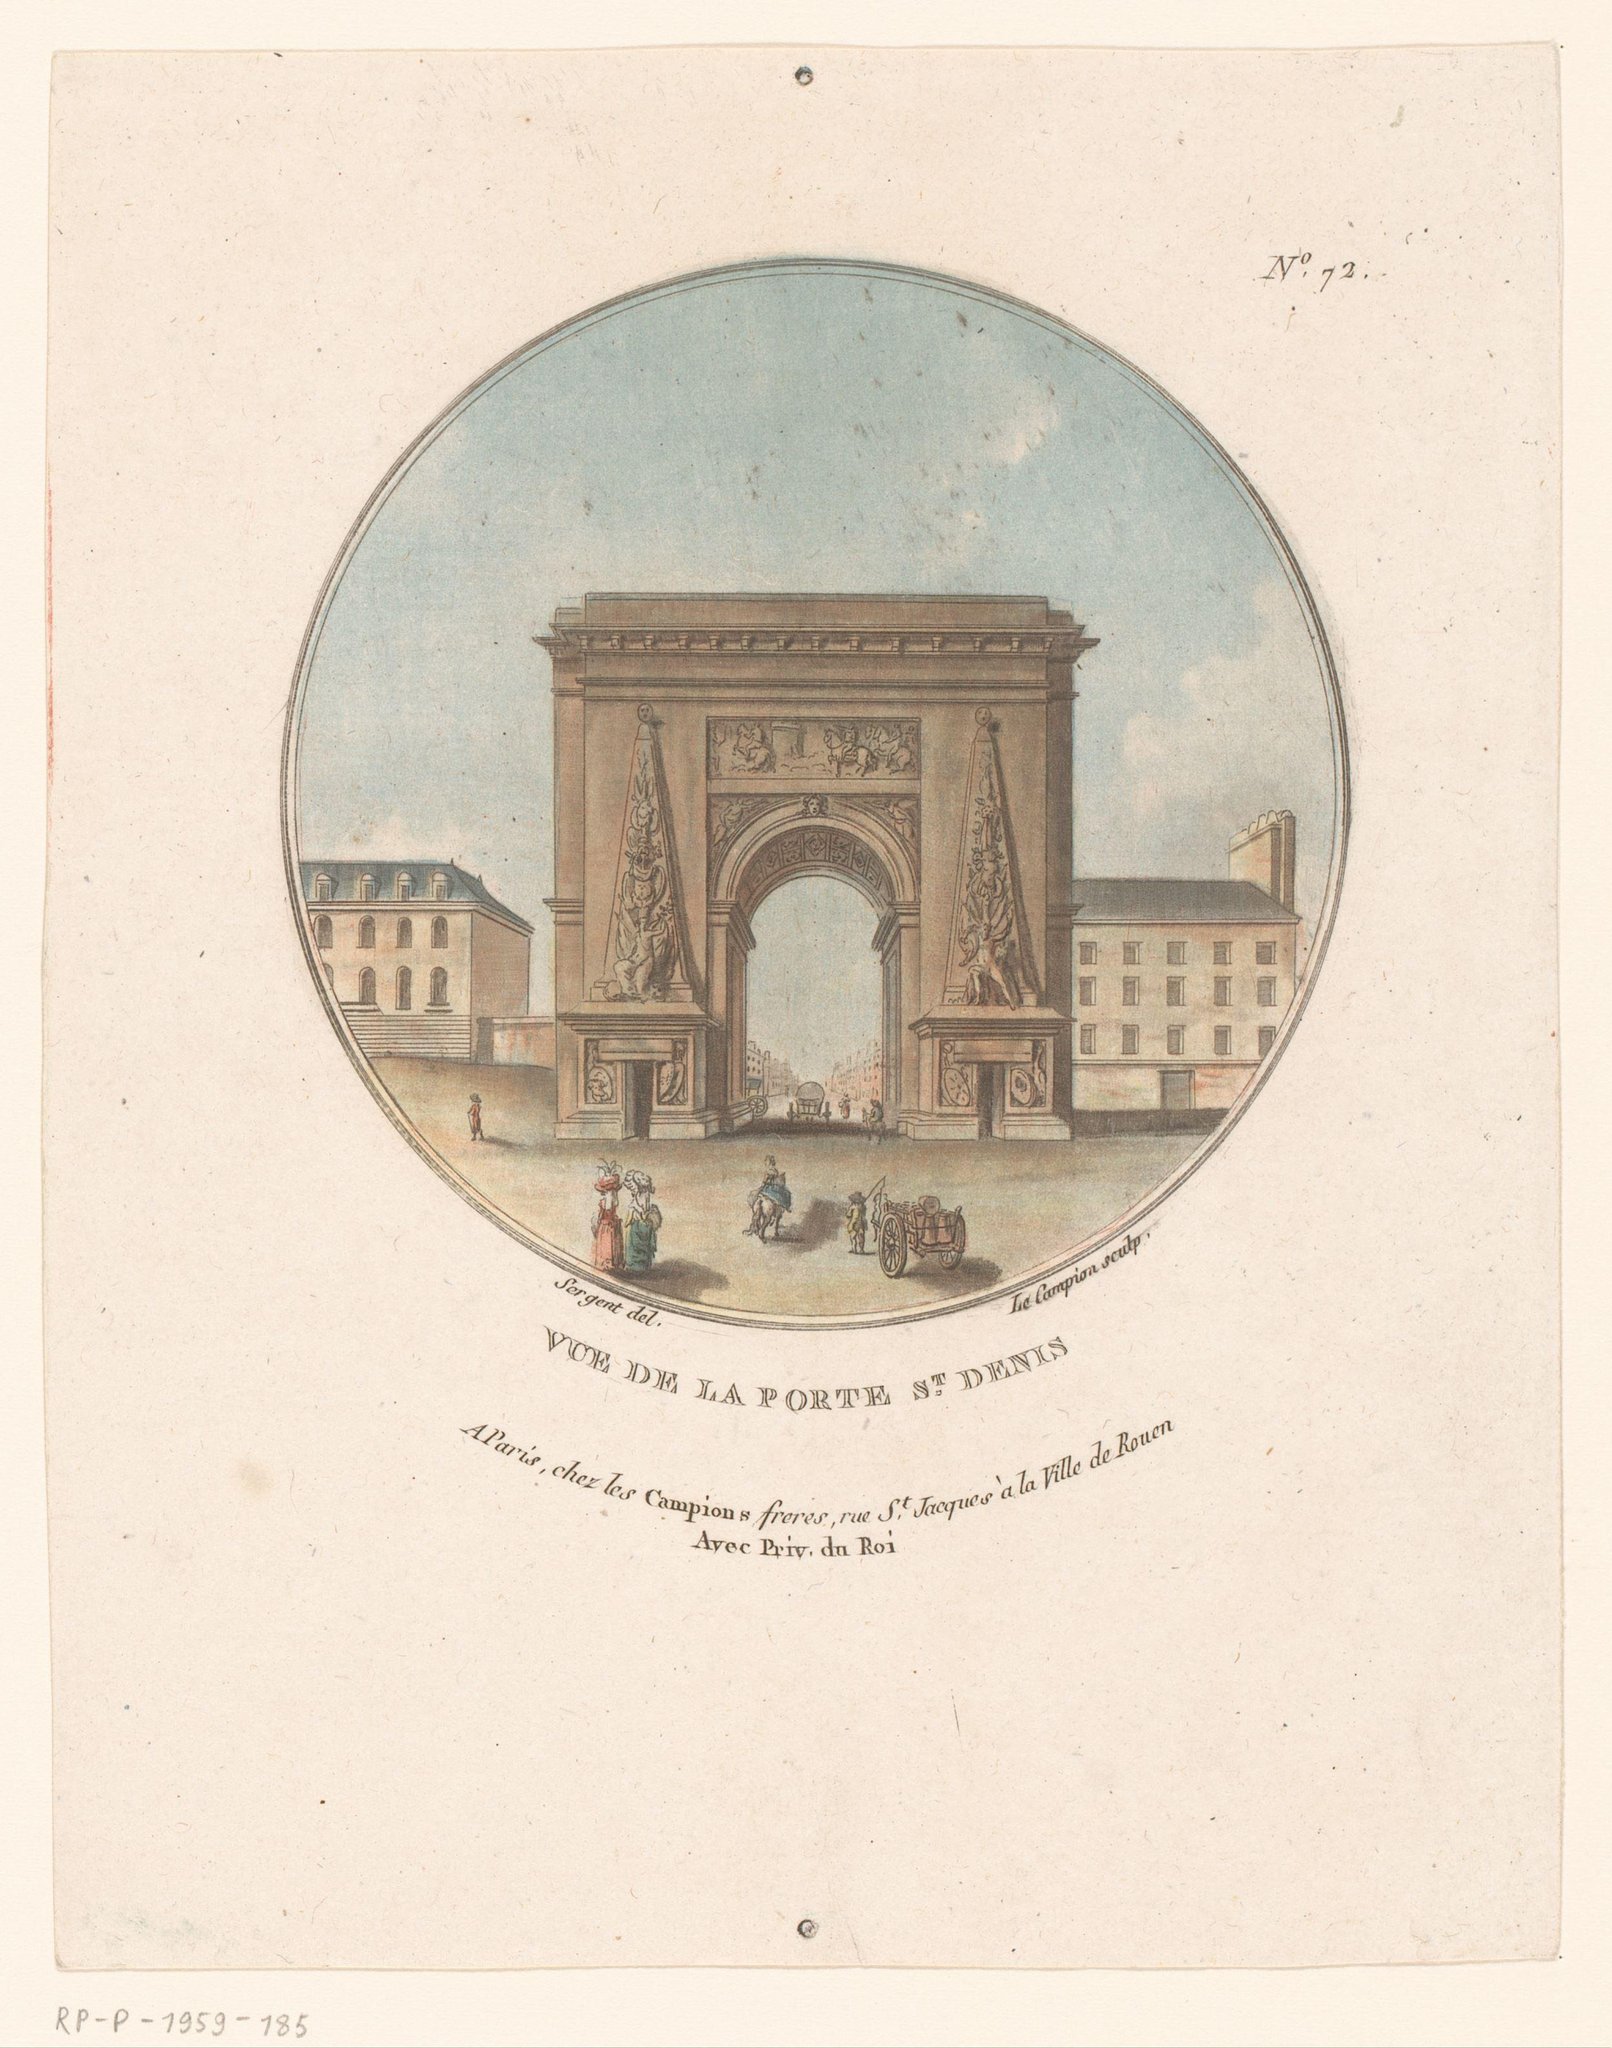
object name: print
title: Vue de la porte St. Denis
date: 1788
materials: paper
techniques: etching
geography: paris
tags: gate, entrance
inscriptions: collector's mark: Lugt 2228, collector's mark: Lugt 2760